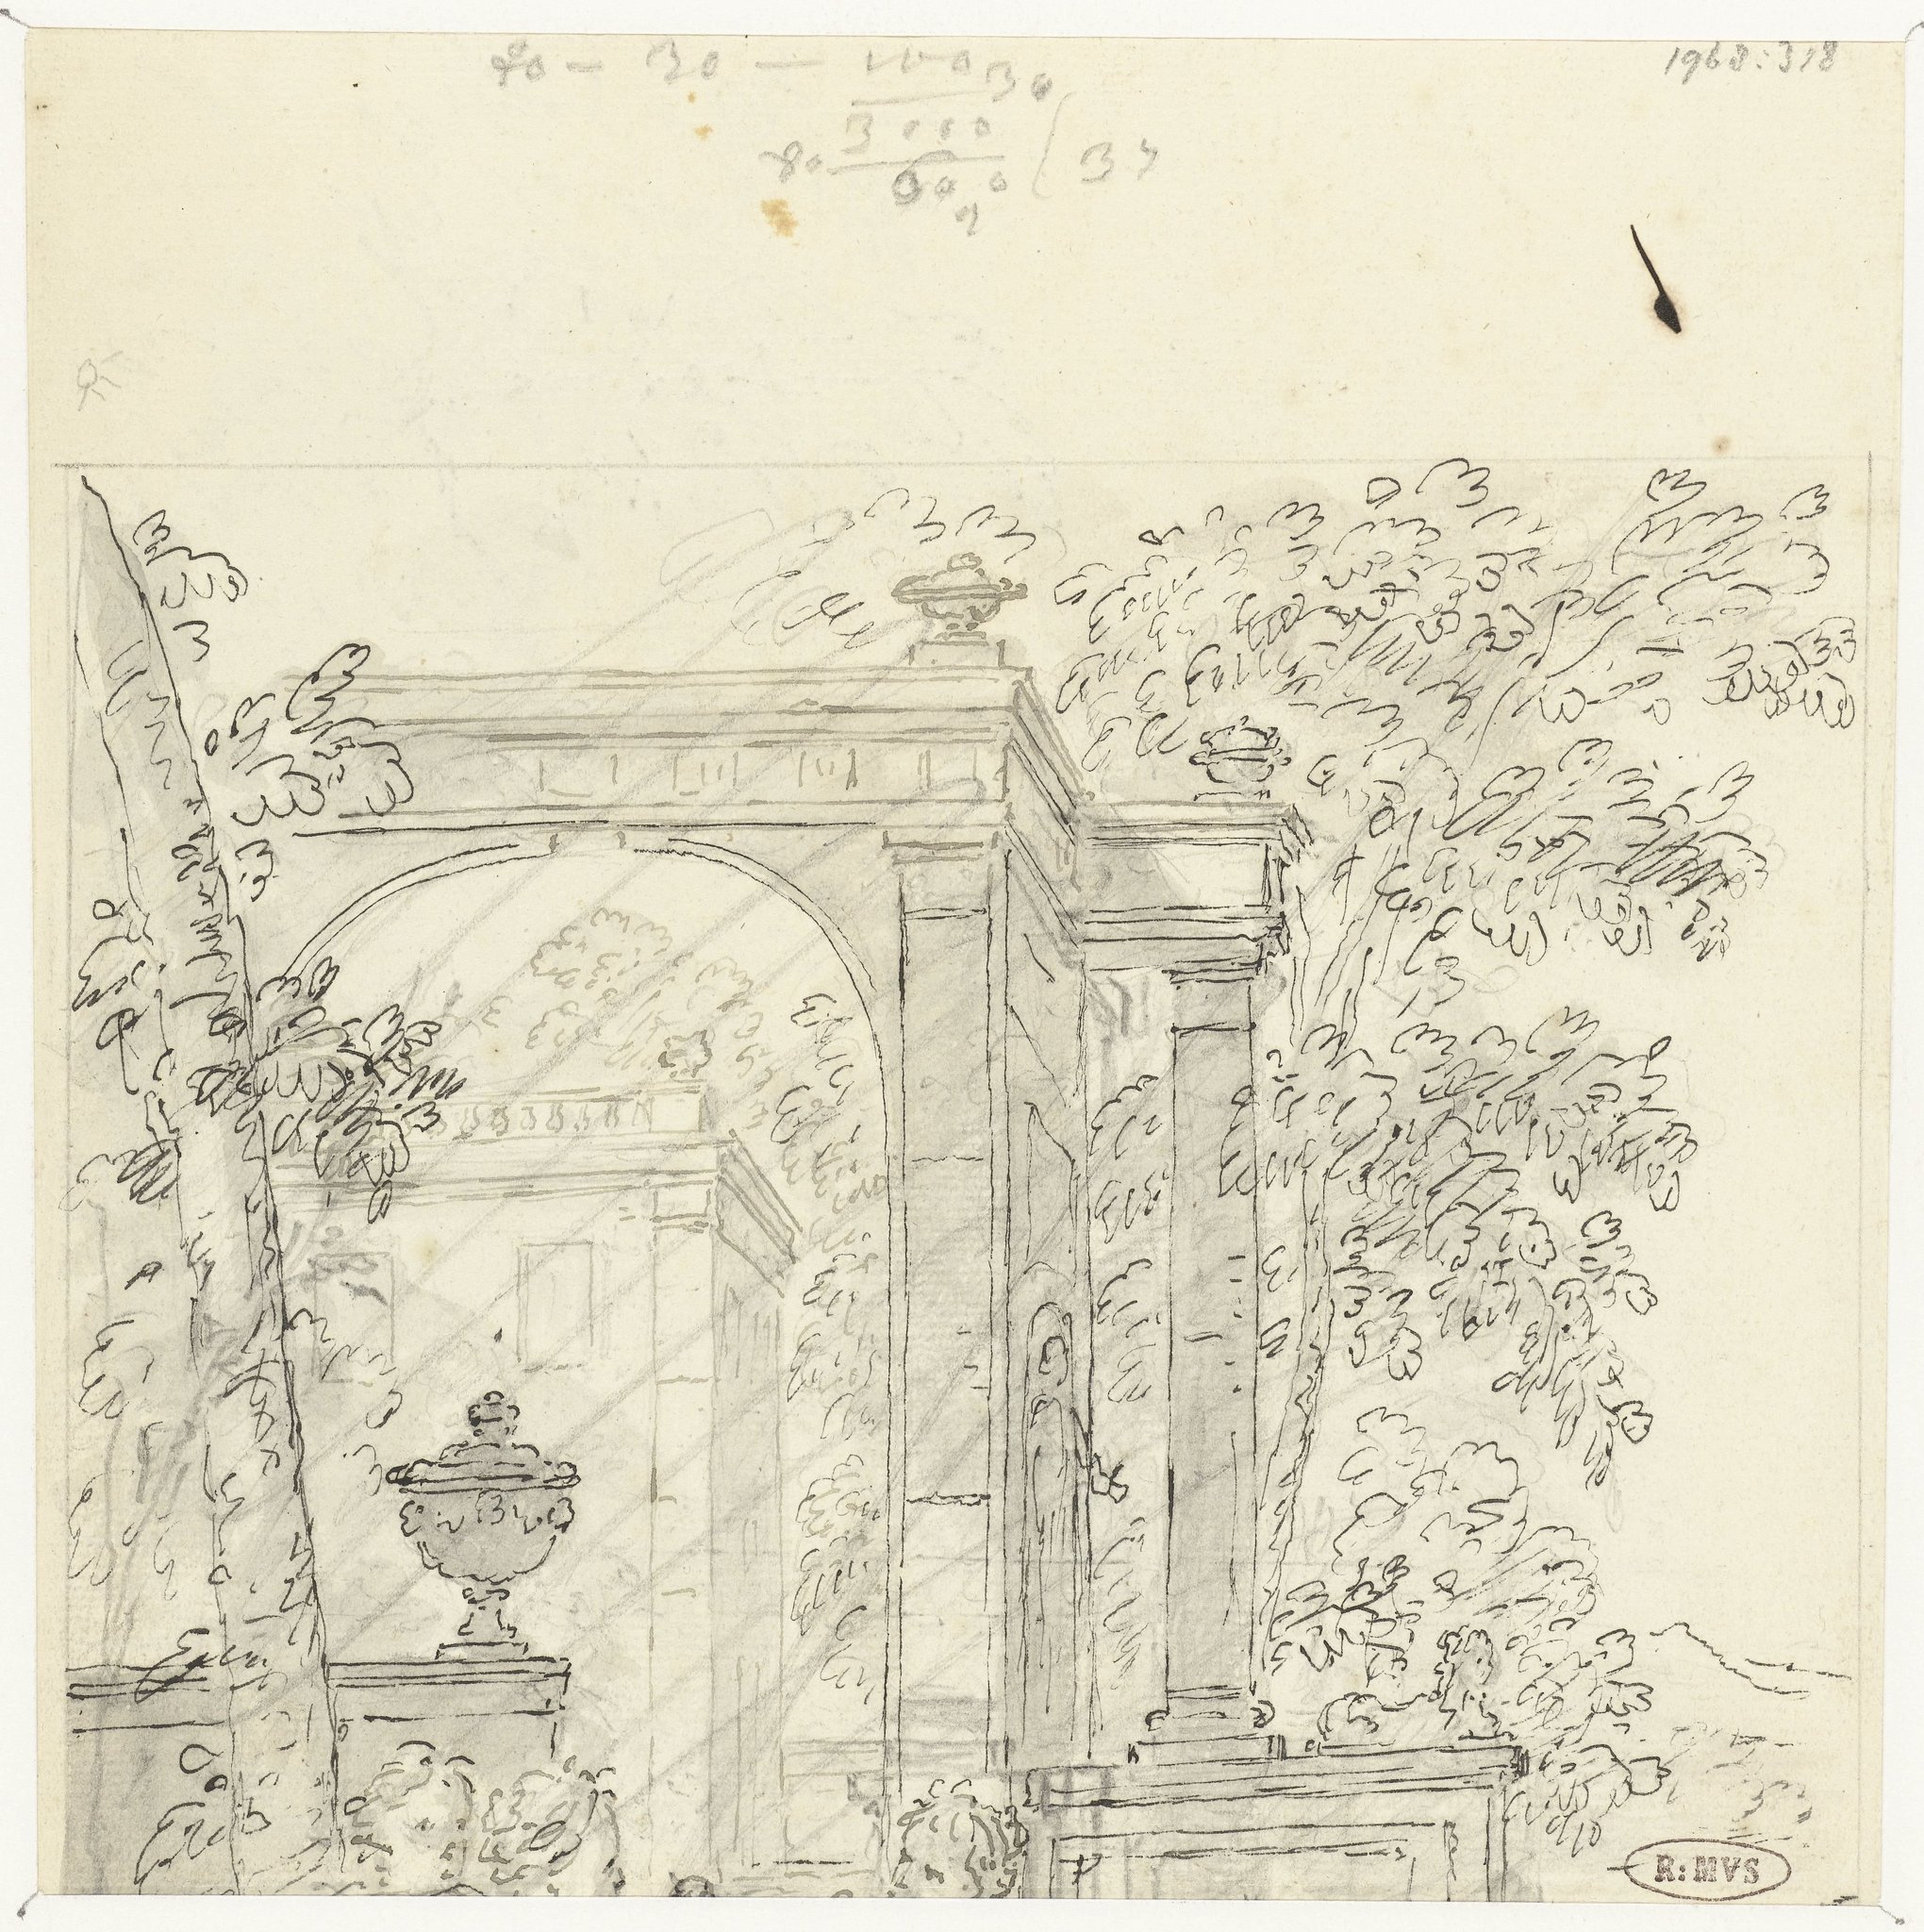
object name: design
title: Fragment van een tuingezicht met architectuur en figuren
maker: dionys van nijmegen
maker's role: draughtsman, painter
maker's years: 1705-1798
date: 1715-1798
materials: ink, paper, pencil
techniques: brush, pen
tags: garden